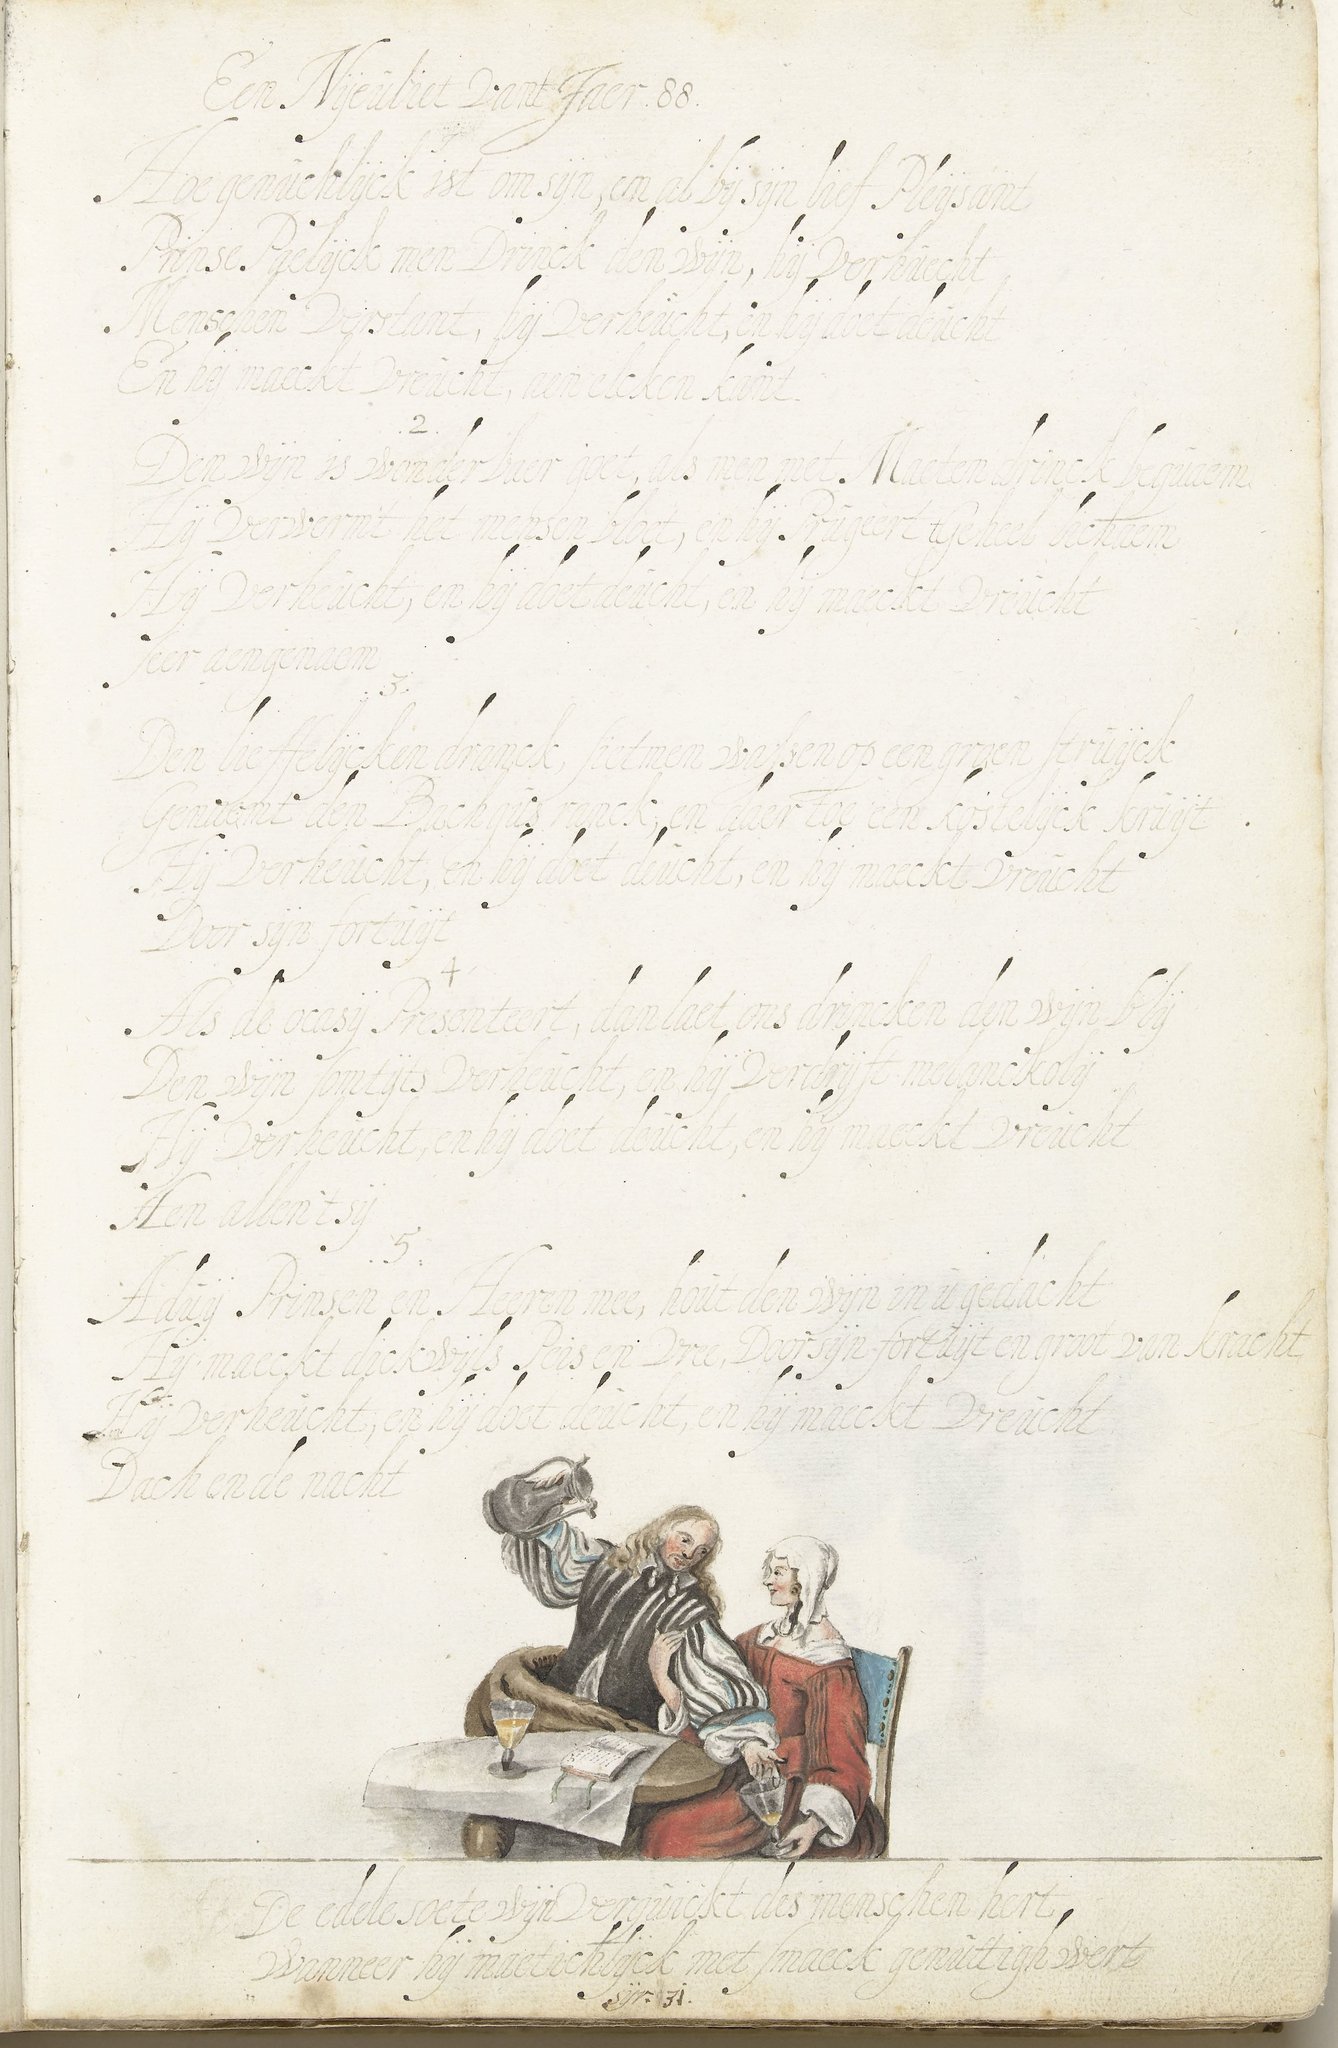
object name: drawing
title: Een Nijeuliet vant jaer 88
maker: gesina ter borch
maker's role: draughtsman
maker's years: 1633-1690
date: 1652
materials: ink, paper, watercolor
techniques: brush, calligraphy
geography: zwolle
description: Oud Rederijker lied. Gesina heeft onderaan in haar eigen woorden een variant op de geciteerde Bijbelse tekst toegevoegd. Tekening naar schilderij van Gerard ter Borch de Jonge (Aanmoediging om te drinken, waarschijnlijk 1648).